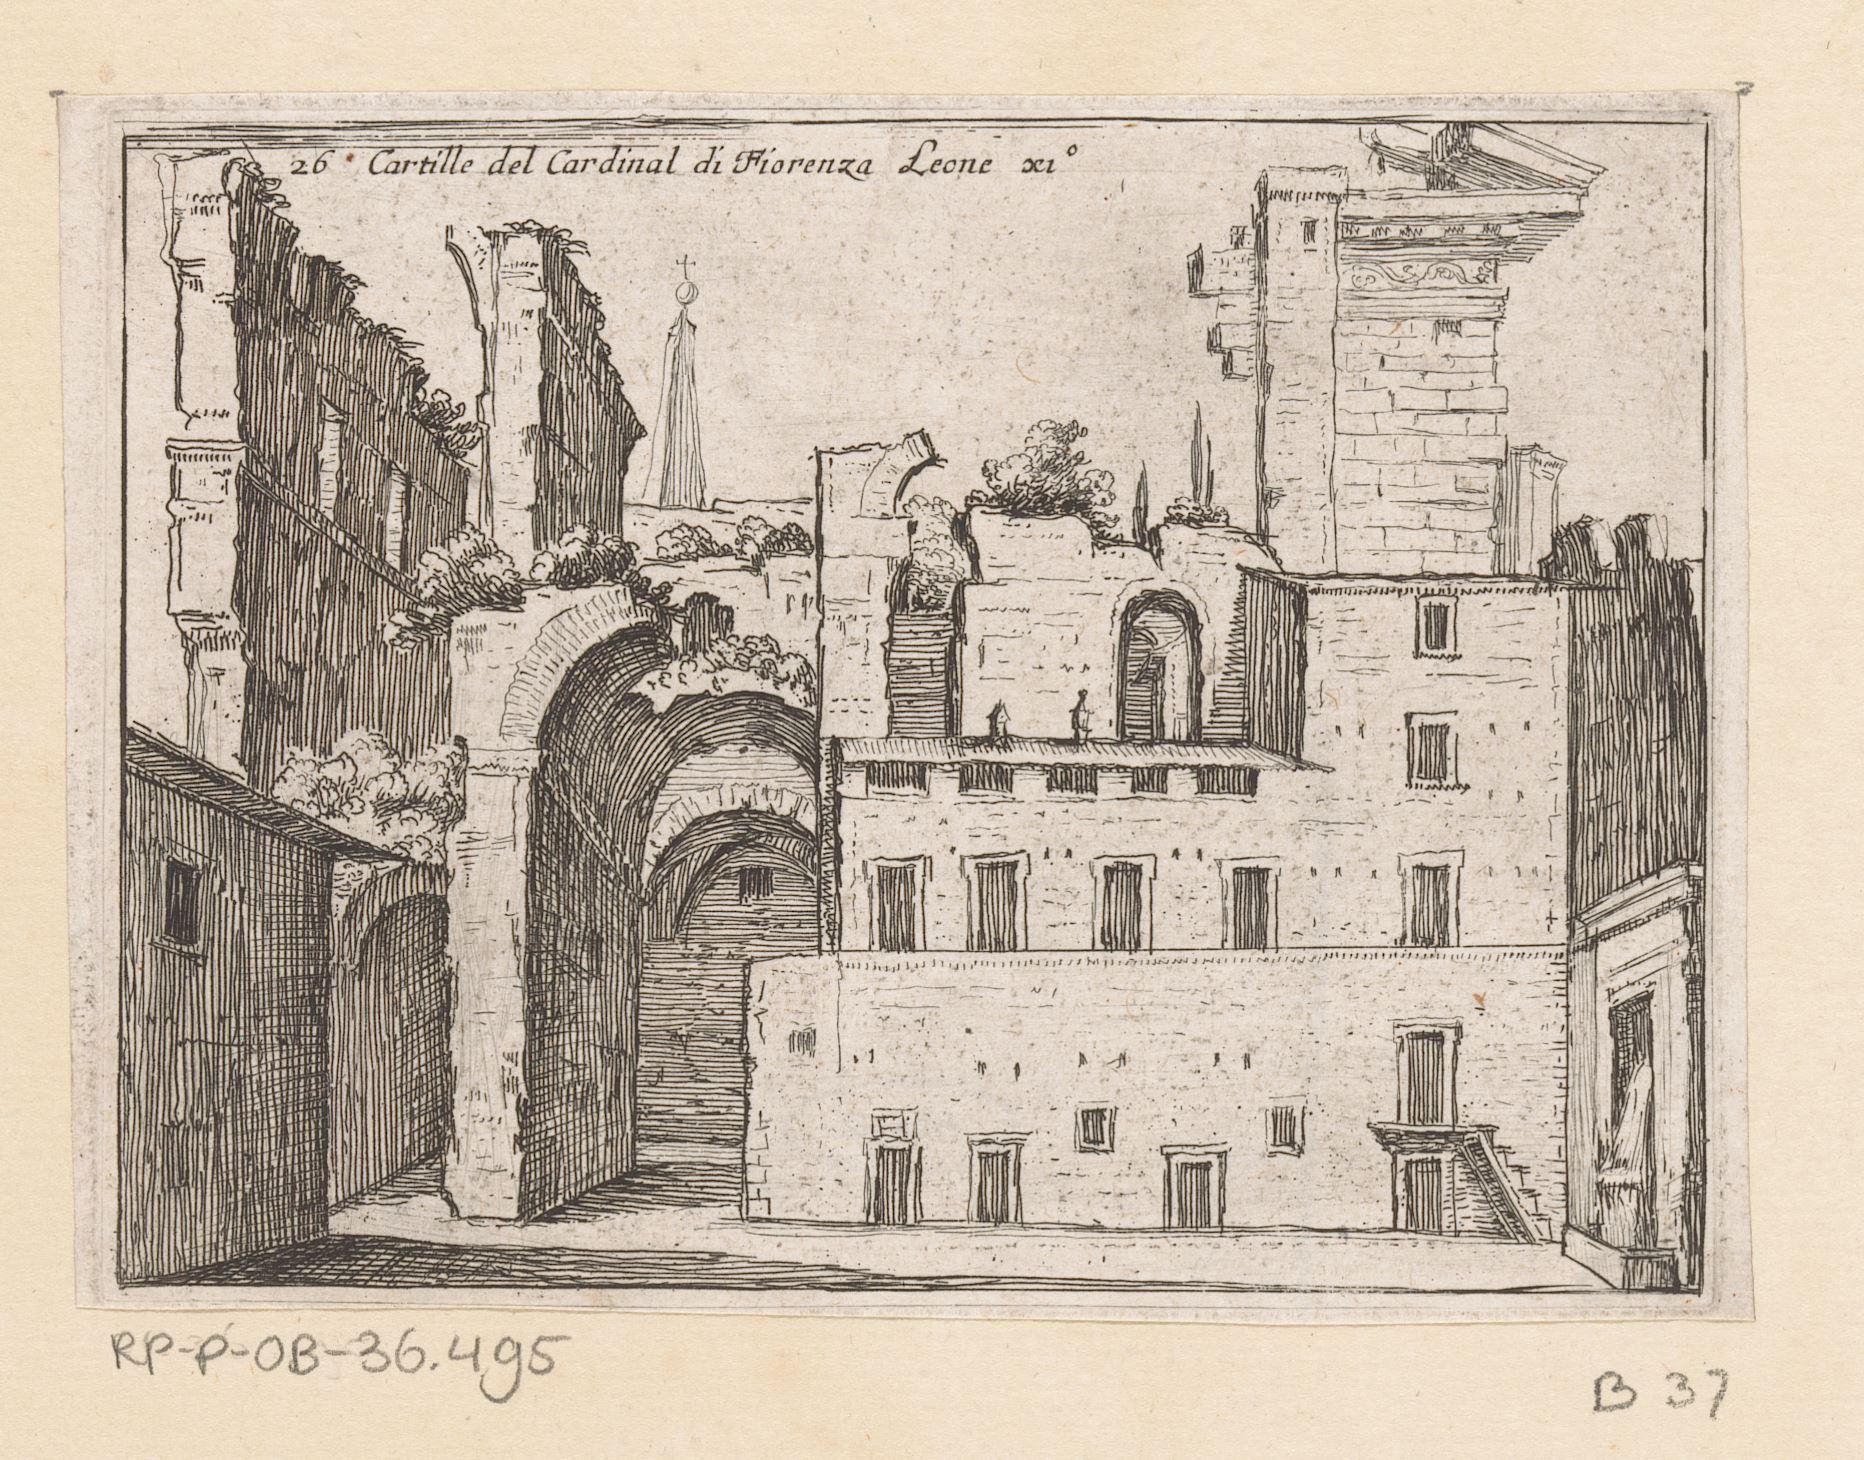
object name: print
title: Gezichten op Rome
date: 1629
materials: paper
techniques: etching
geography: tuscany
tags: landscape with ruins, rome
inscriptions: collector's mark: Lugt 2228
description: Gezicht op de resten van het Serapeum, een tempel gewijd aan de god Serapis, op de Quirinaal-heuvel nabij Palazzo Colonna te Rome.